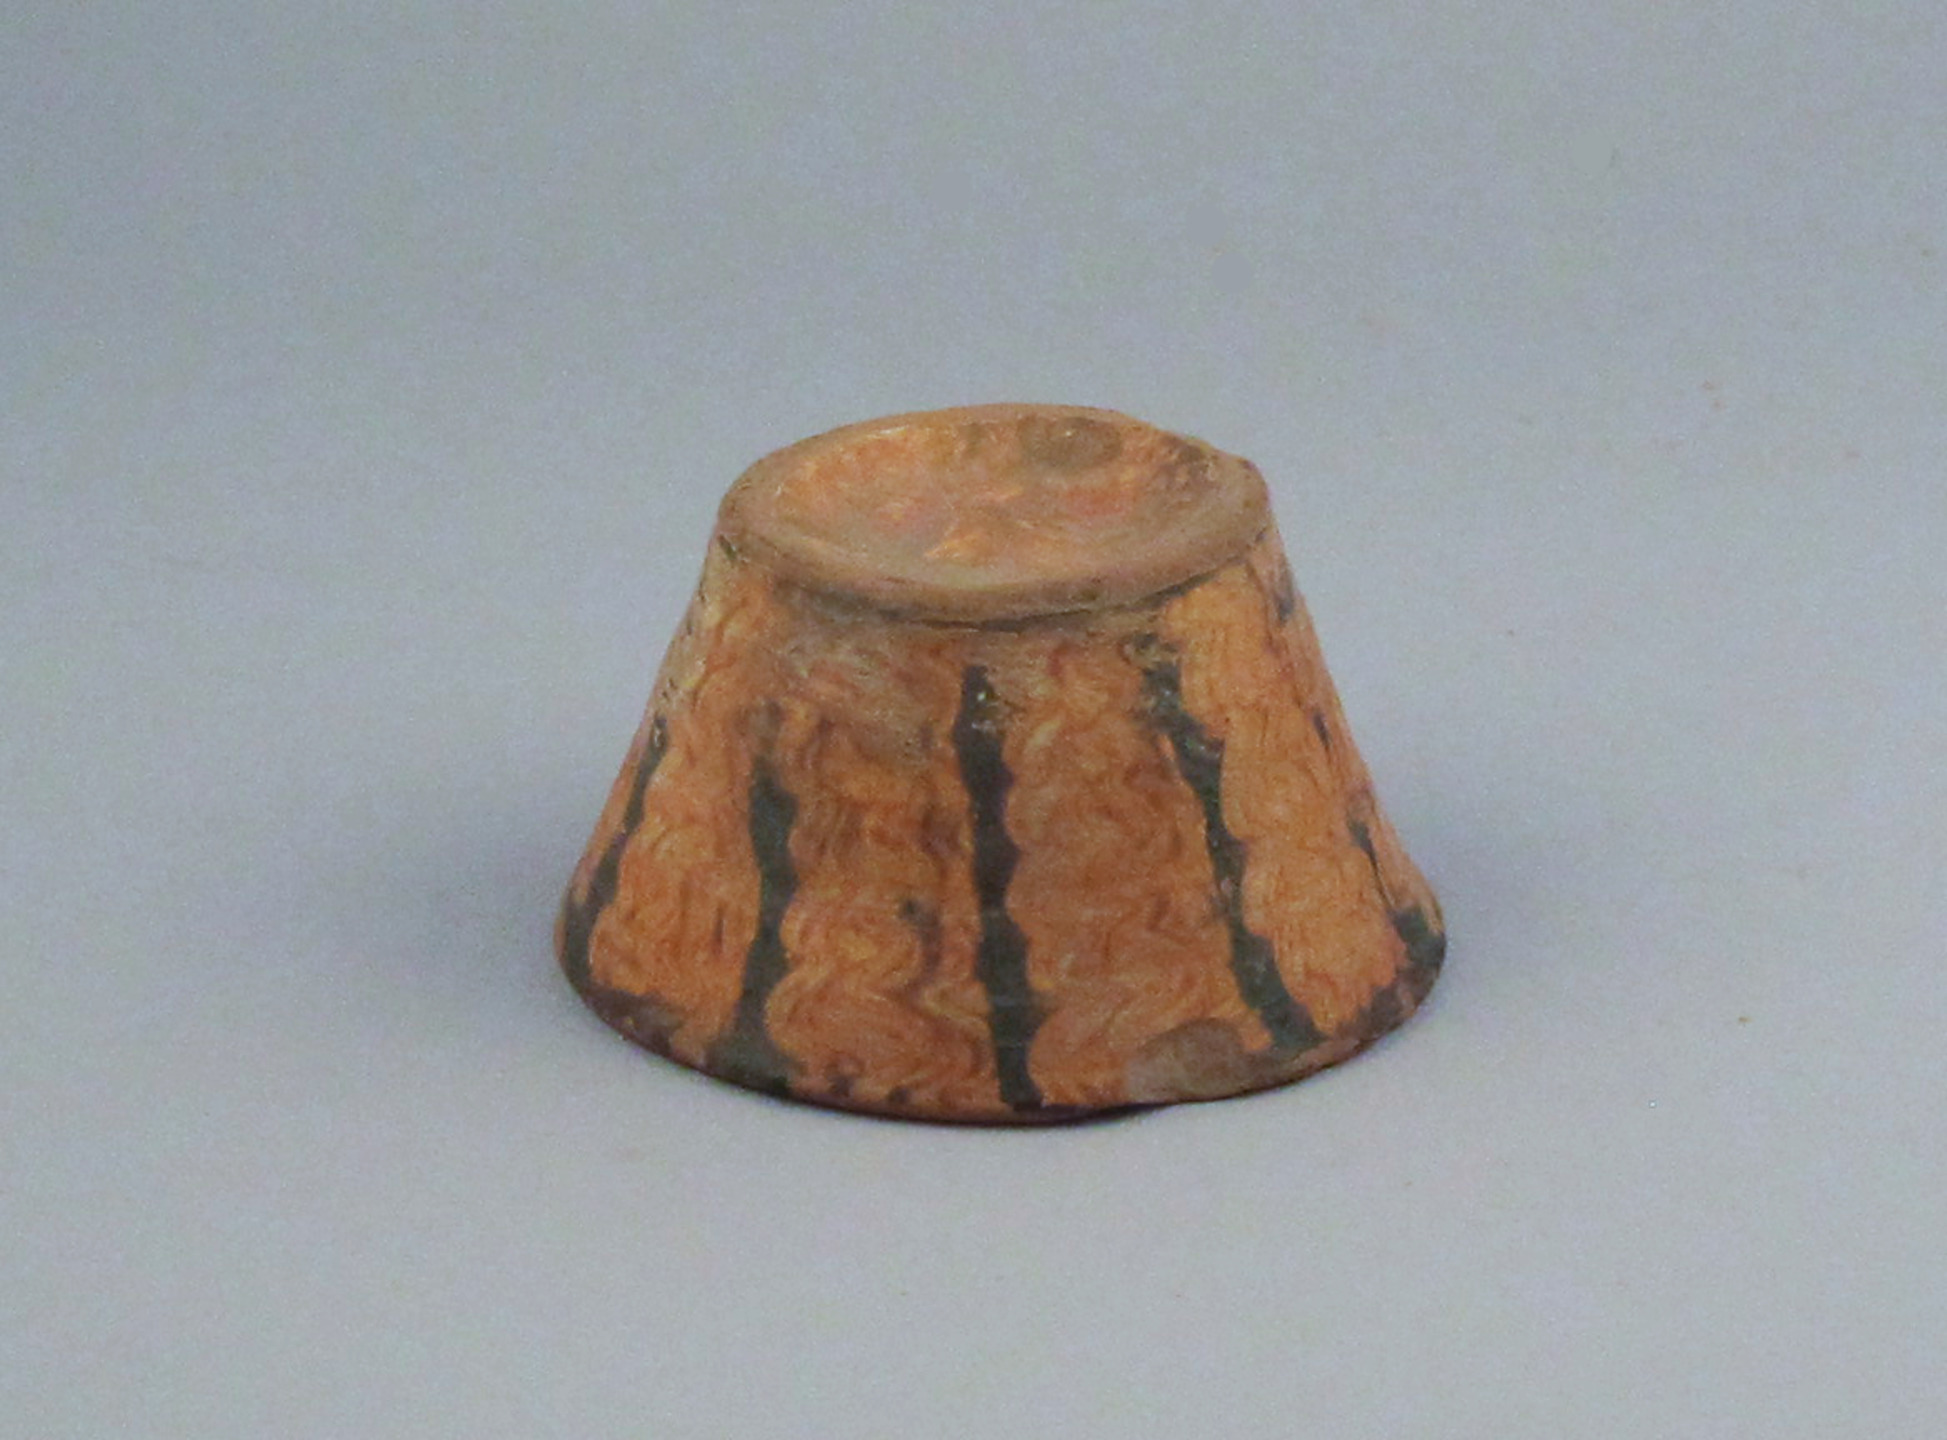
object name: vase fragment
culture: greek or lydian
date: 900-30 BCE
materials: terracotta